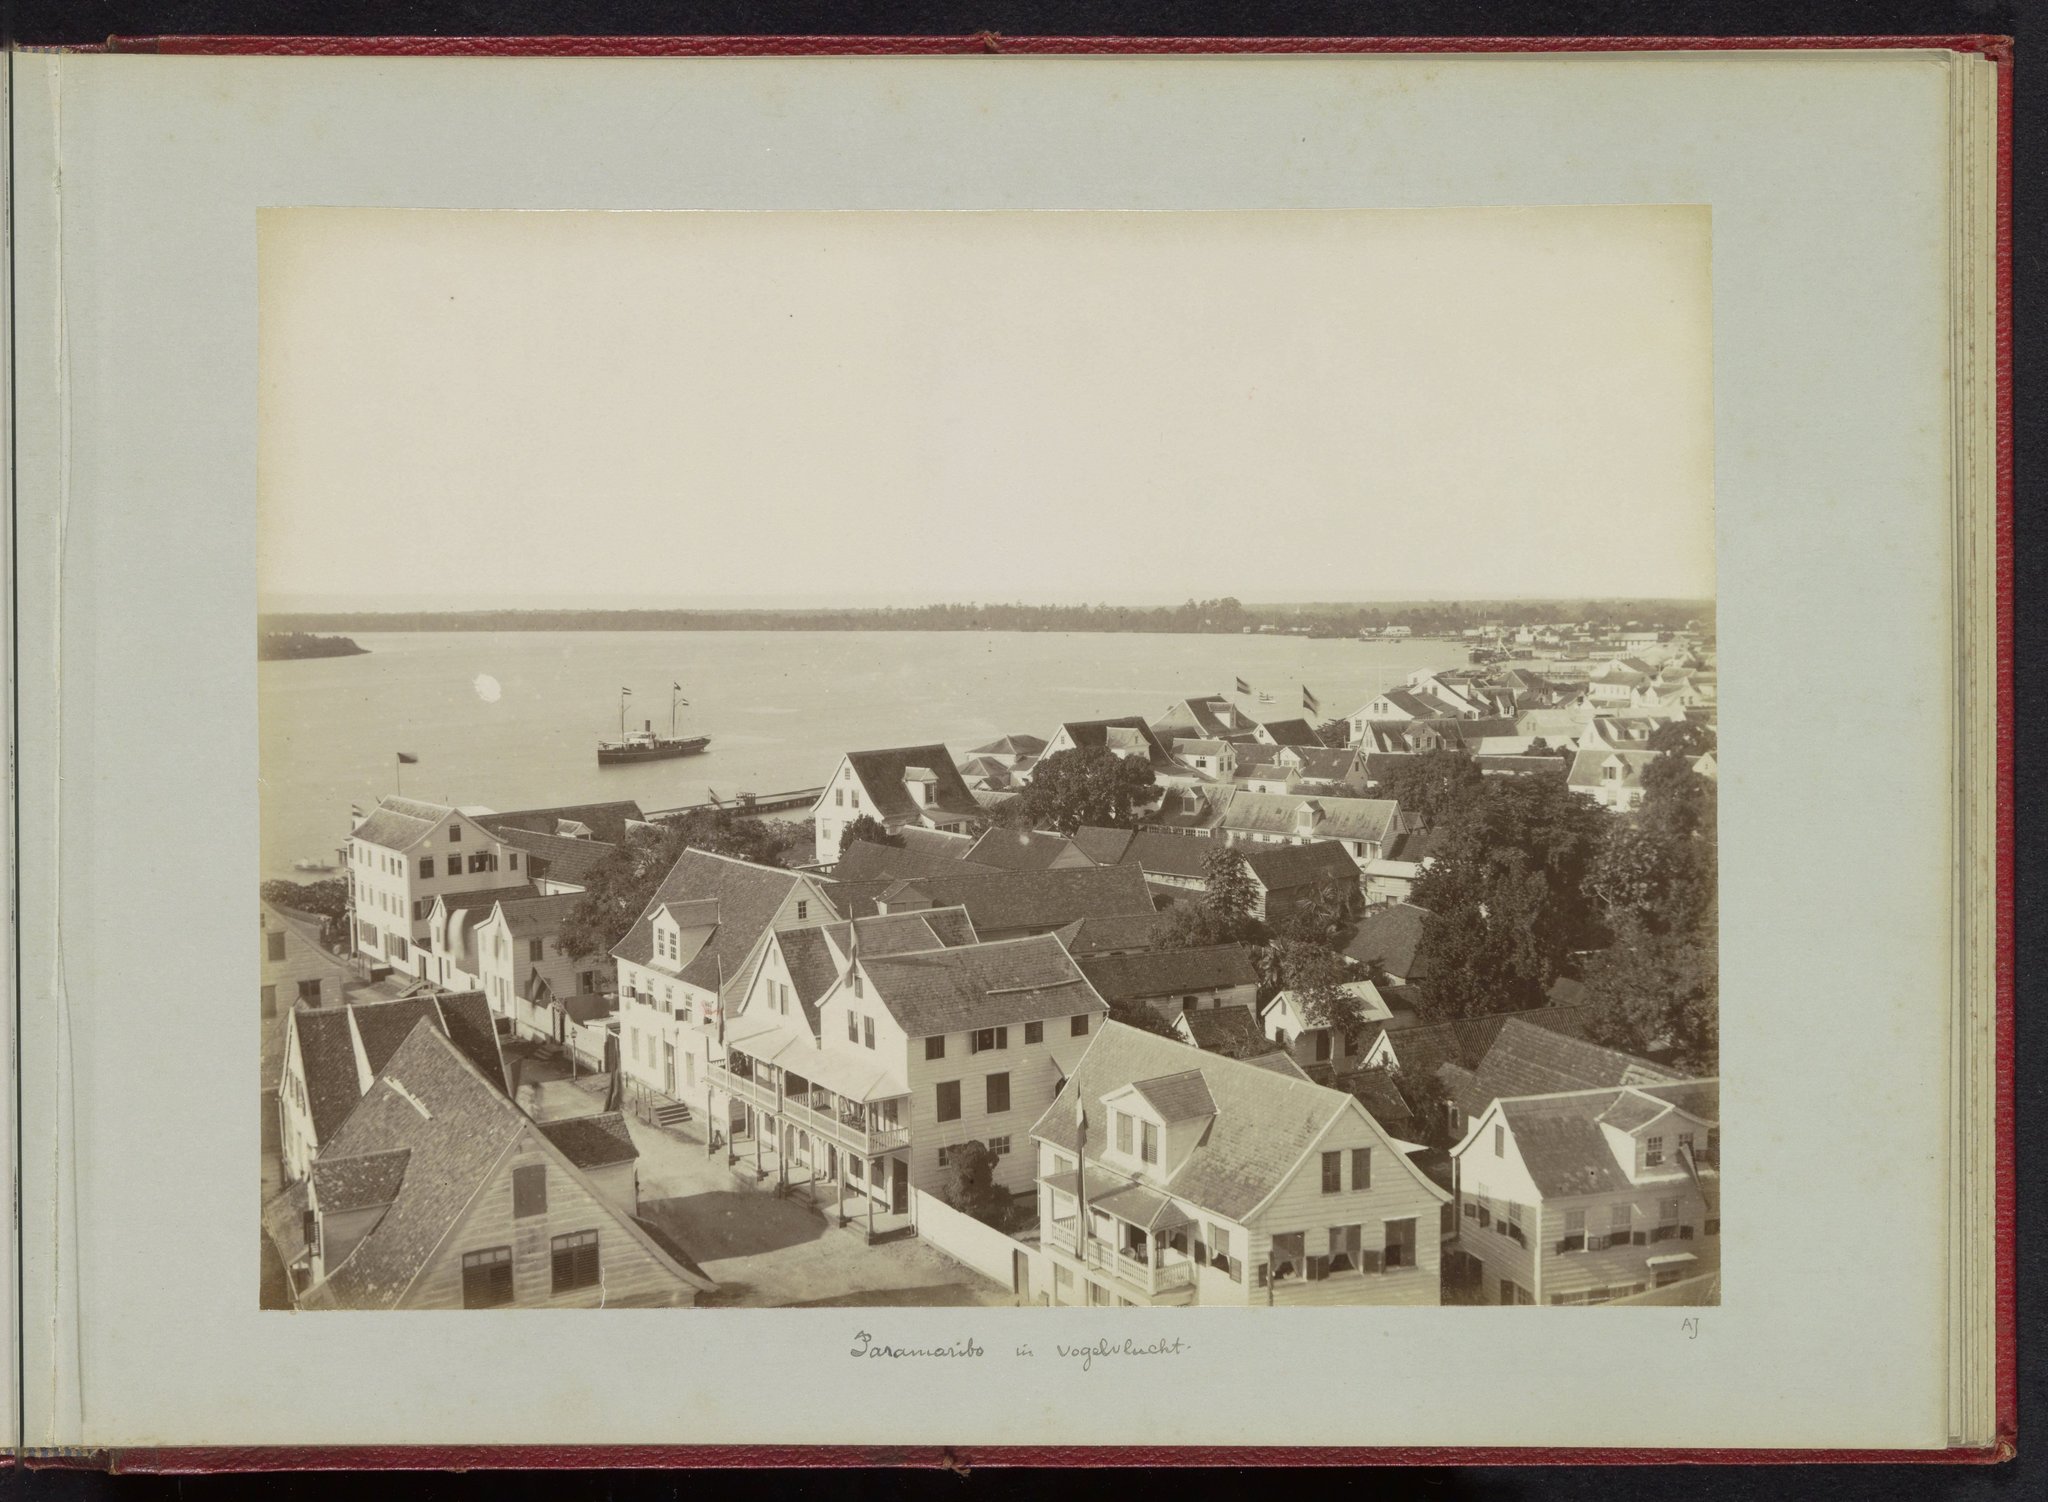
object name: photograph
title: Gezicht op Paramaribo en de Surinamerivier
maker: julius muller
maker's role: official, politician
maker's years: 1846-1902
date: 1890-1900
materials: photographic support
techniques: albumen print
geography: paramaribo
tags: prospect of city, town panorama, silhouette of city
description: Onderdeel van Fotoalbum met opnames van bezienswaardigheden in Europa, Trinidad, Haïti, Martinique en Suriname.